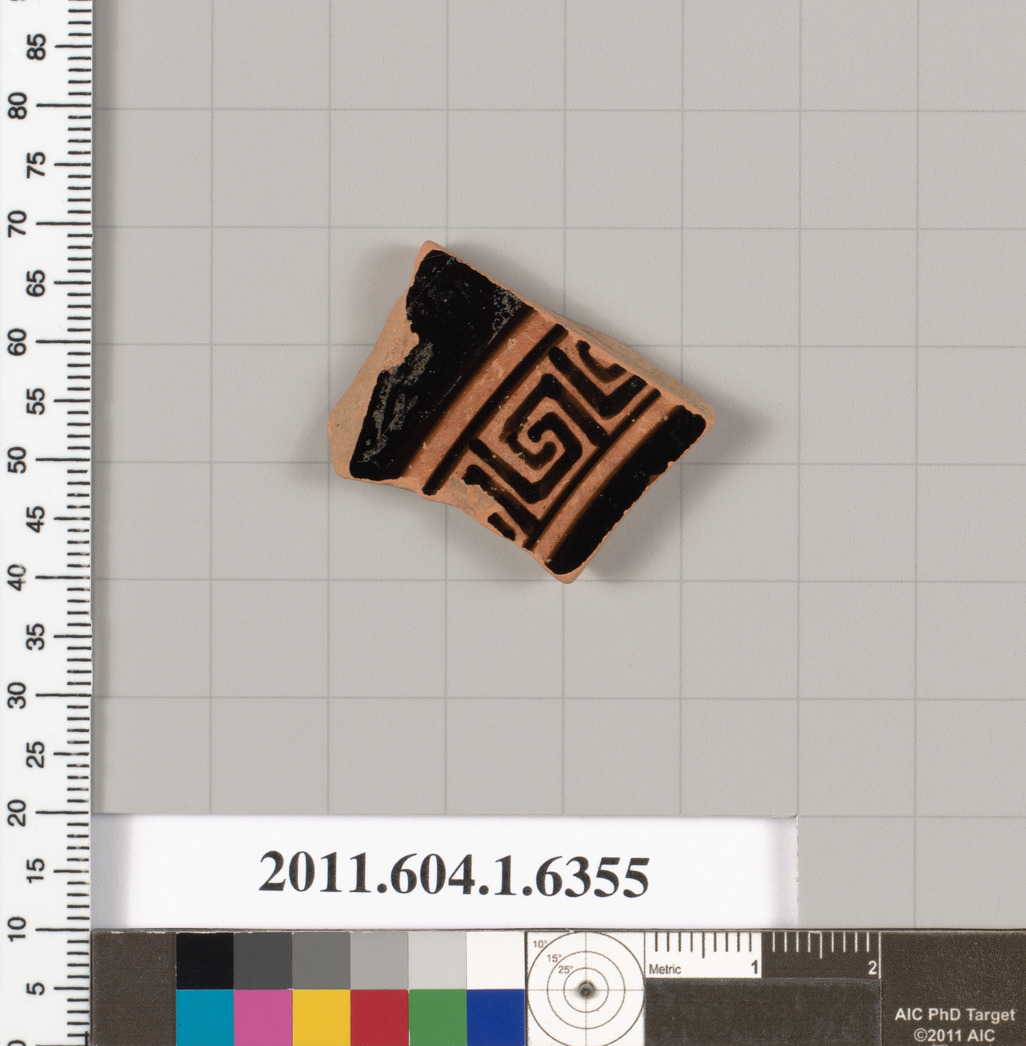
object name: kylix fragment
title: Terracotta fragment of a kylix (drinking cup)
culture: greek, attic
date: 500-480 BCE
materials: terracotta